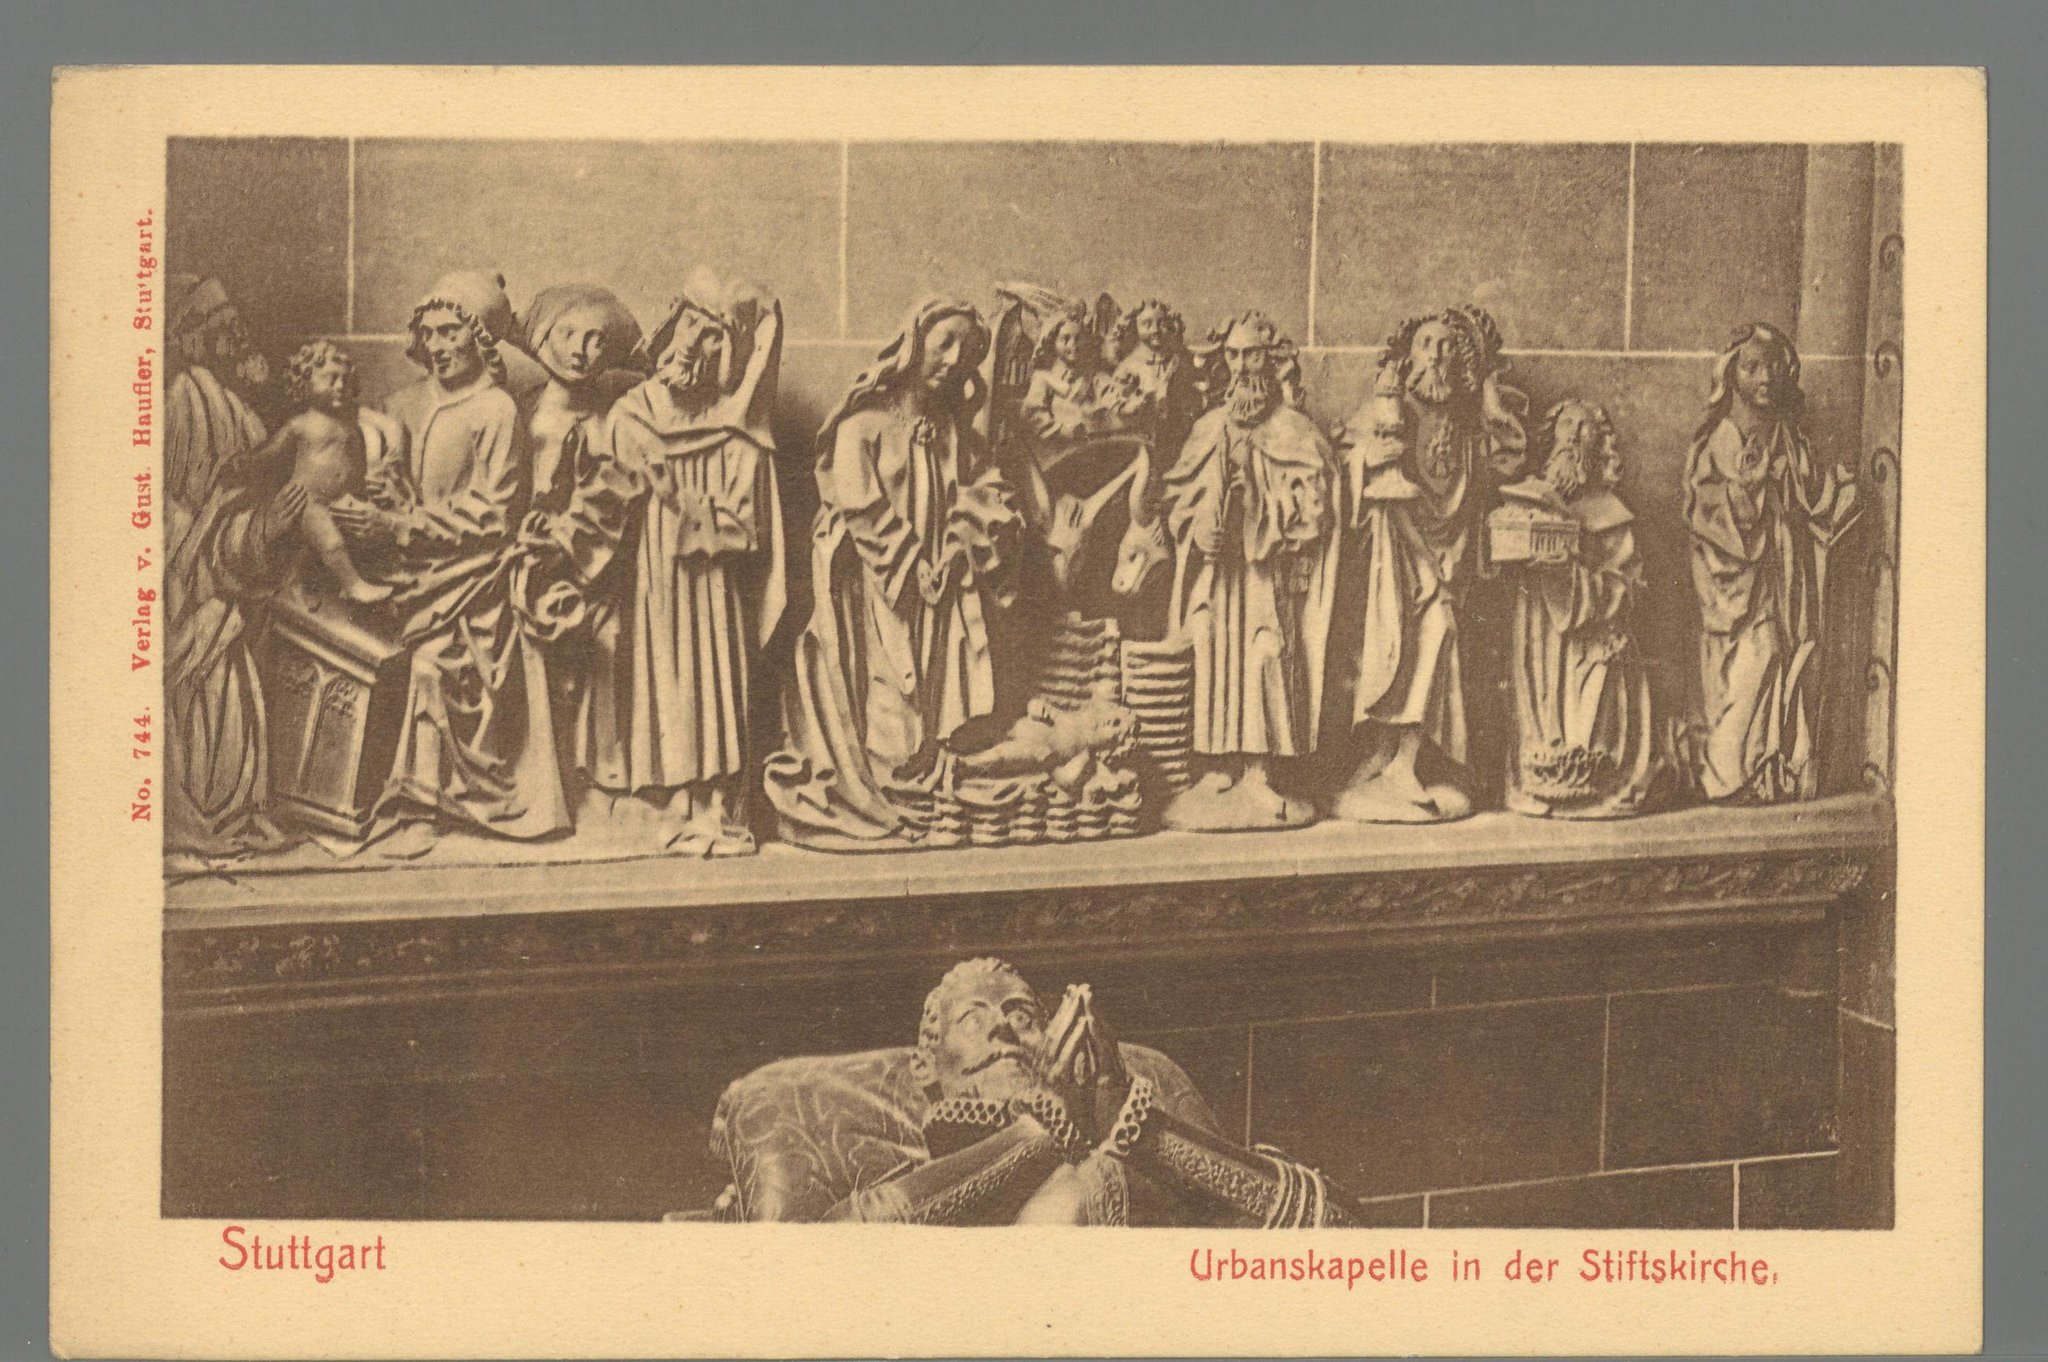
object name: photomechanical print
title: Stuttgart. Urbanskapelle in der Stiftskirche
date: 1905-1930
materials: cardboard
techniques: photograph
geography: stuttgart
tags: statues, paintings, etc. ~ objects of worship in roman religion, parts of church interior: chapel